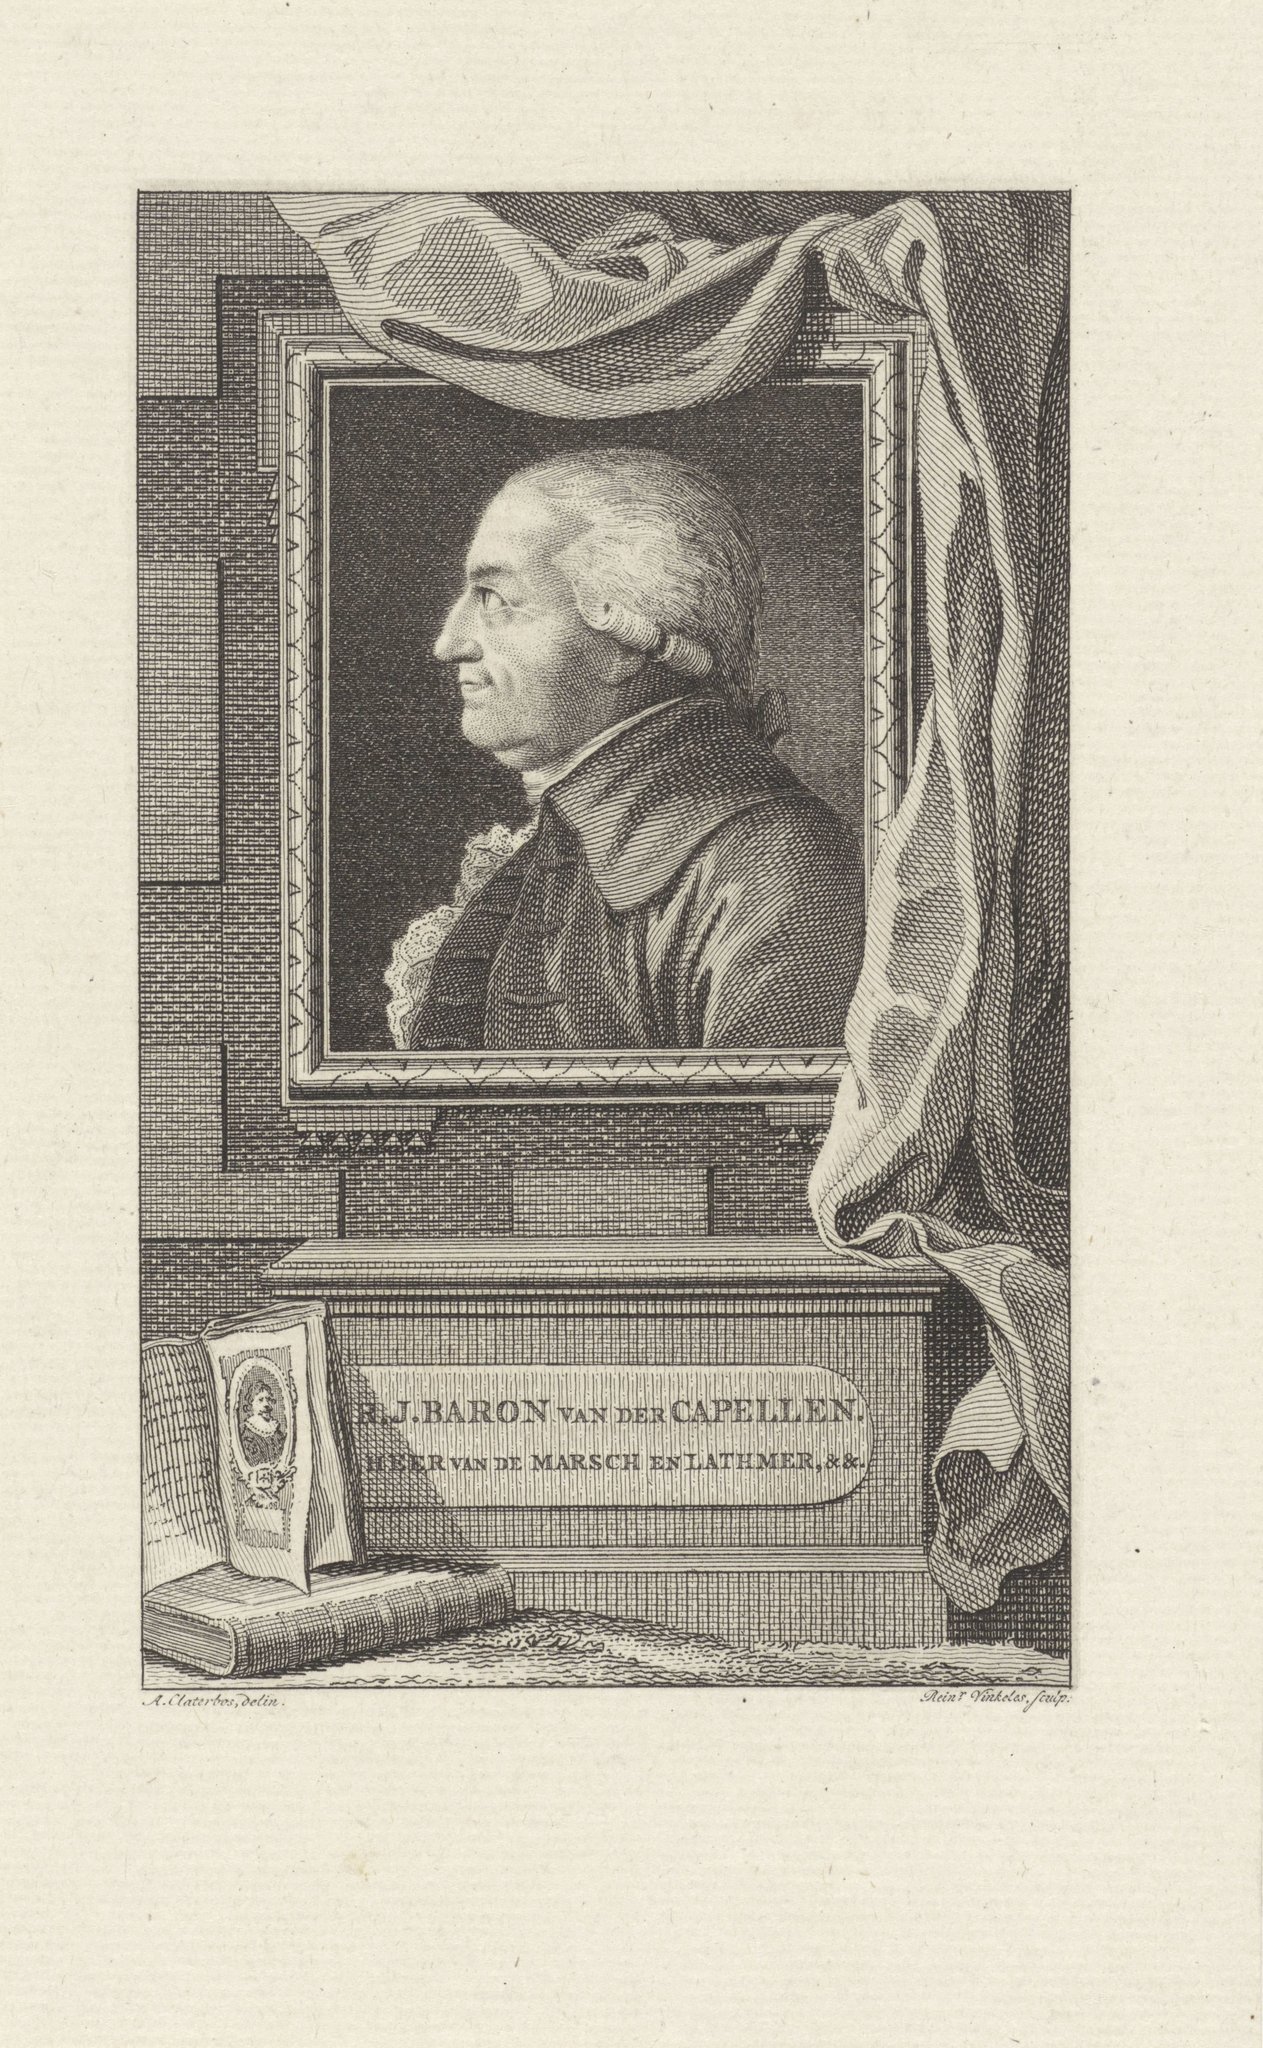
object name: print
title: Portret van Robert Jasper van der Capellen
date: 1786-1809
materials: paper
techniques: engraving, etching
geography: amsterdam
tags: deventer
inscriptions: collector's mark: Lugt 2228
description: Prent ook gebruikt als boekillustratie in: Wagenaar, Jan. Vaderlandsche historie, (...) ten vervolge van Wagenaars Vaderlandsche historie. Dl. 1-43. Amsterdam: Johannes Allart, 1786-1809.